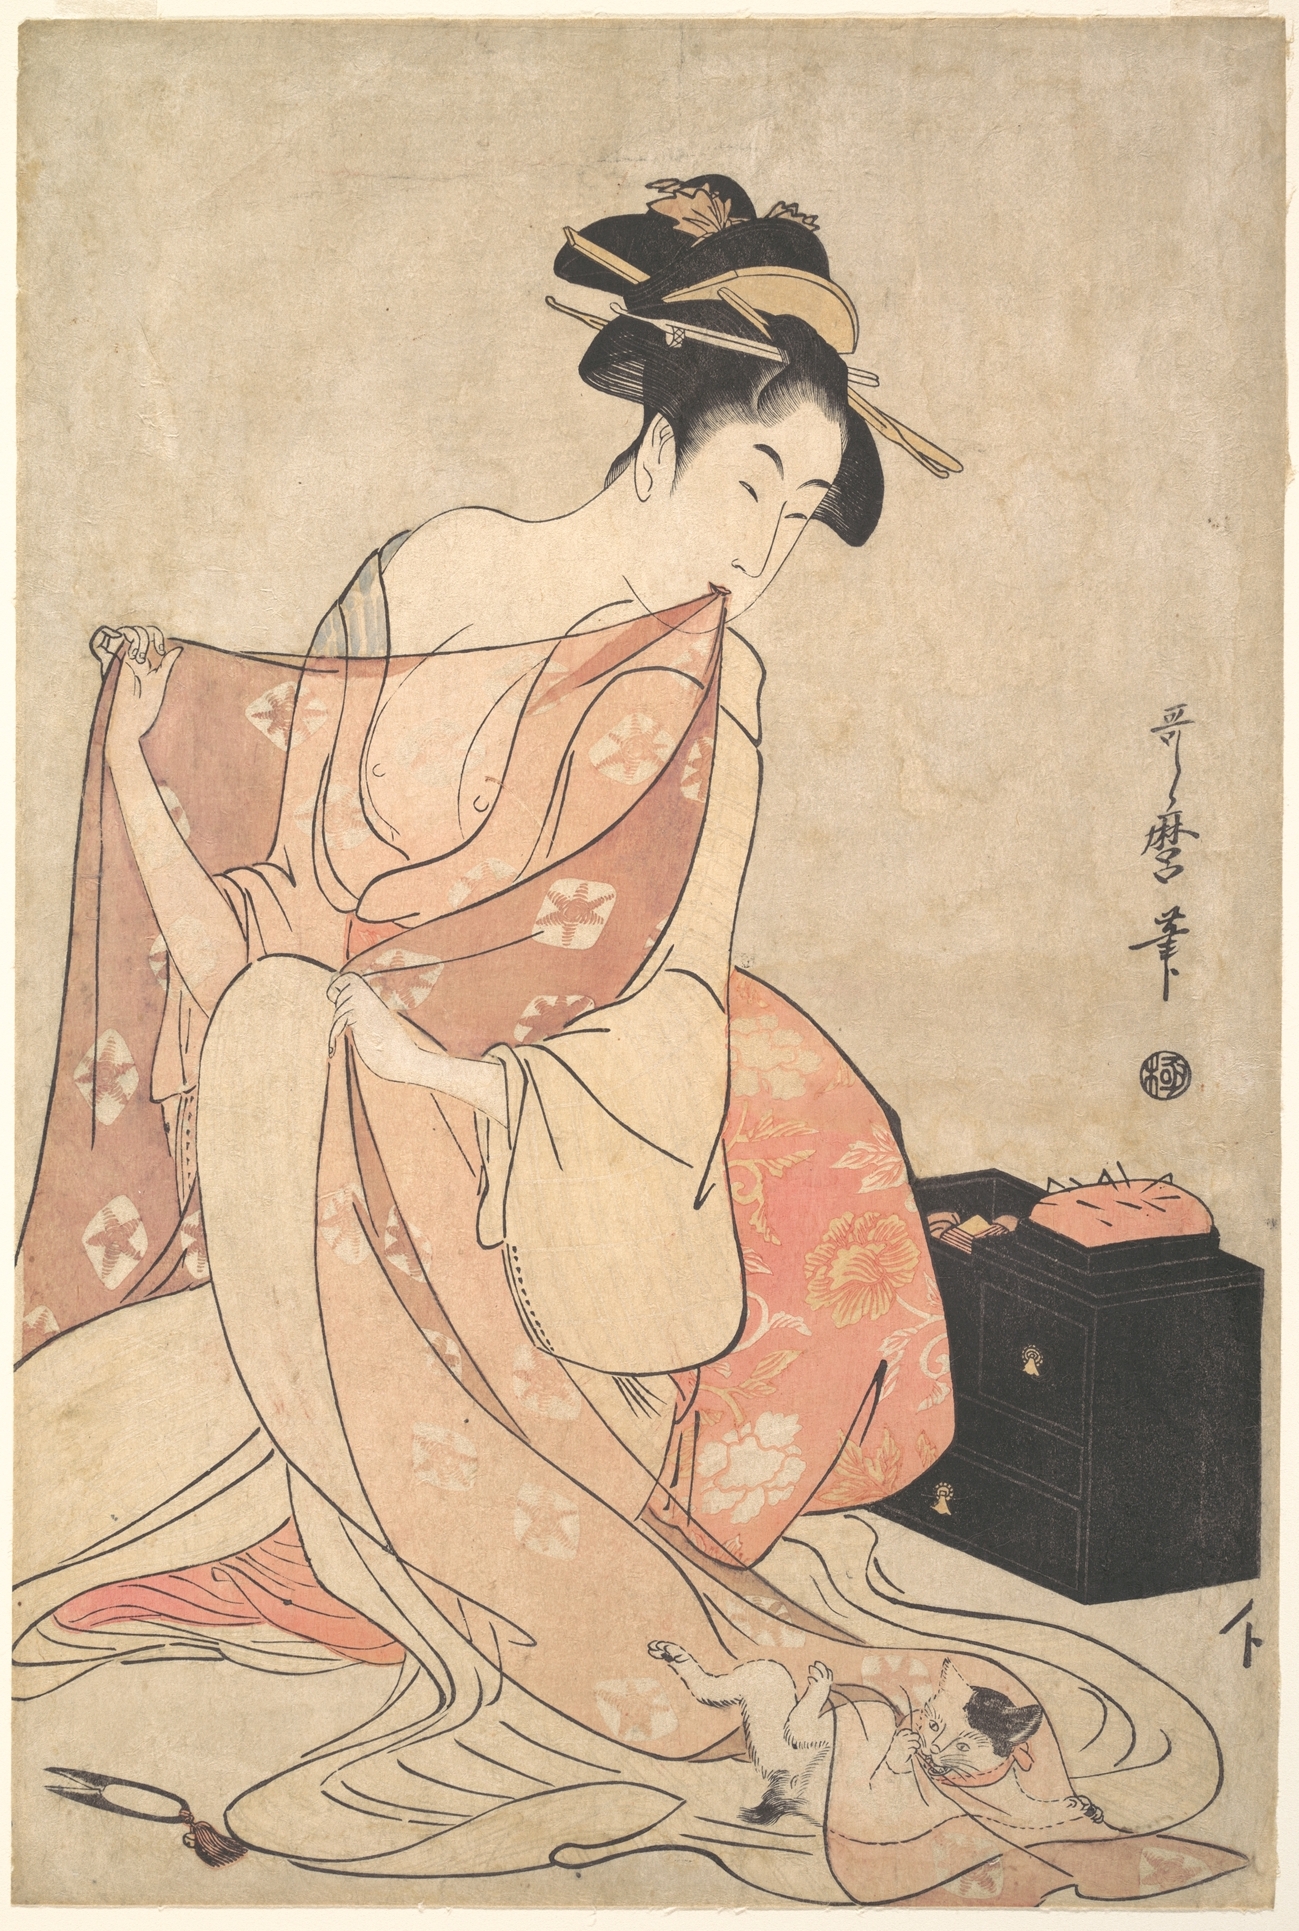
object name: print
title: A Woman and a Cat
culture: japanese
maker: kitagawa utamaro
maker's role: artist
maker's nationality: japanese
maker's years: 1754-1806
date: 1793-1794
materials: ink, paper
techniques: woodblock print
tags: women,cats